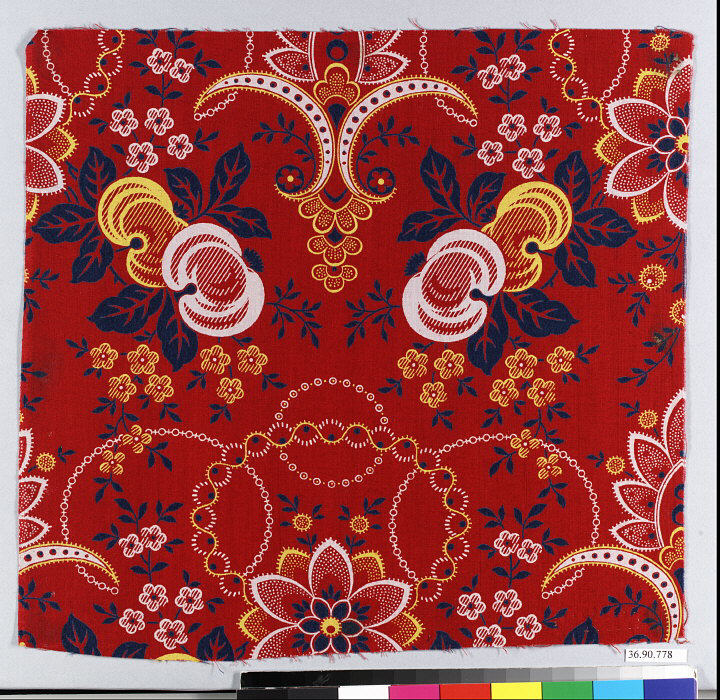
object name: piece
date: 1867-1900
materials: cotton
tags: flowers,leaves